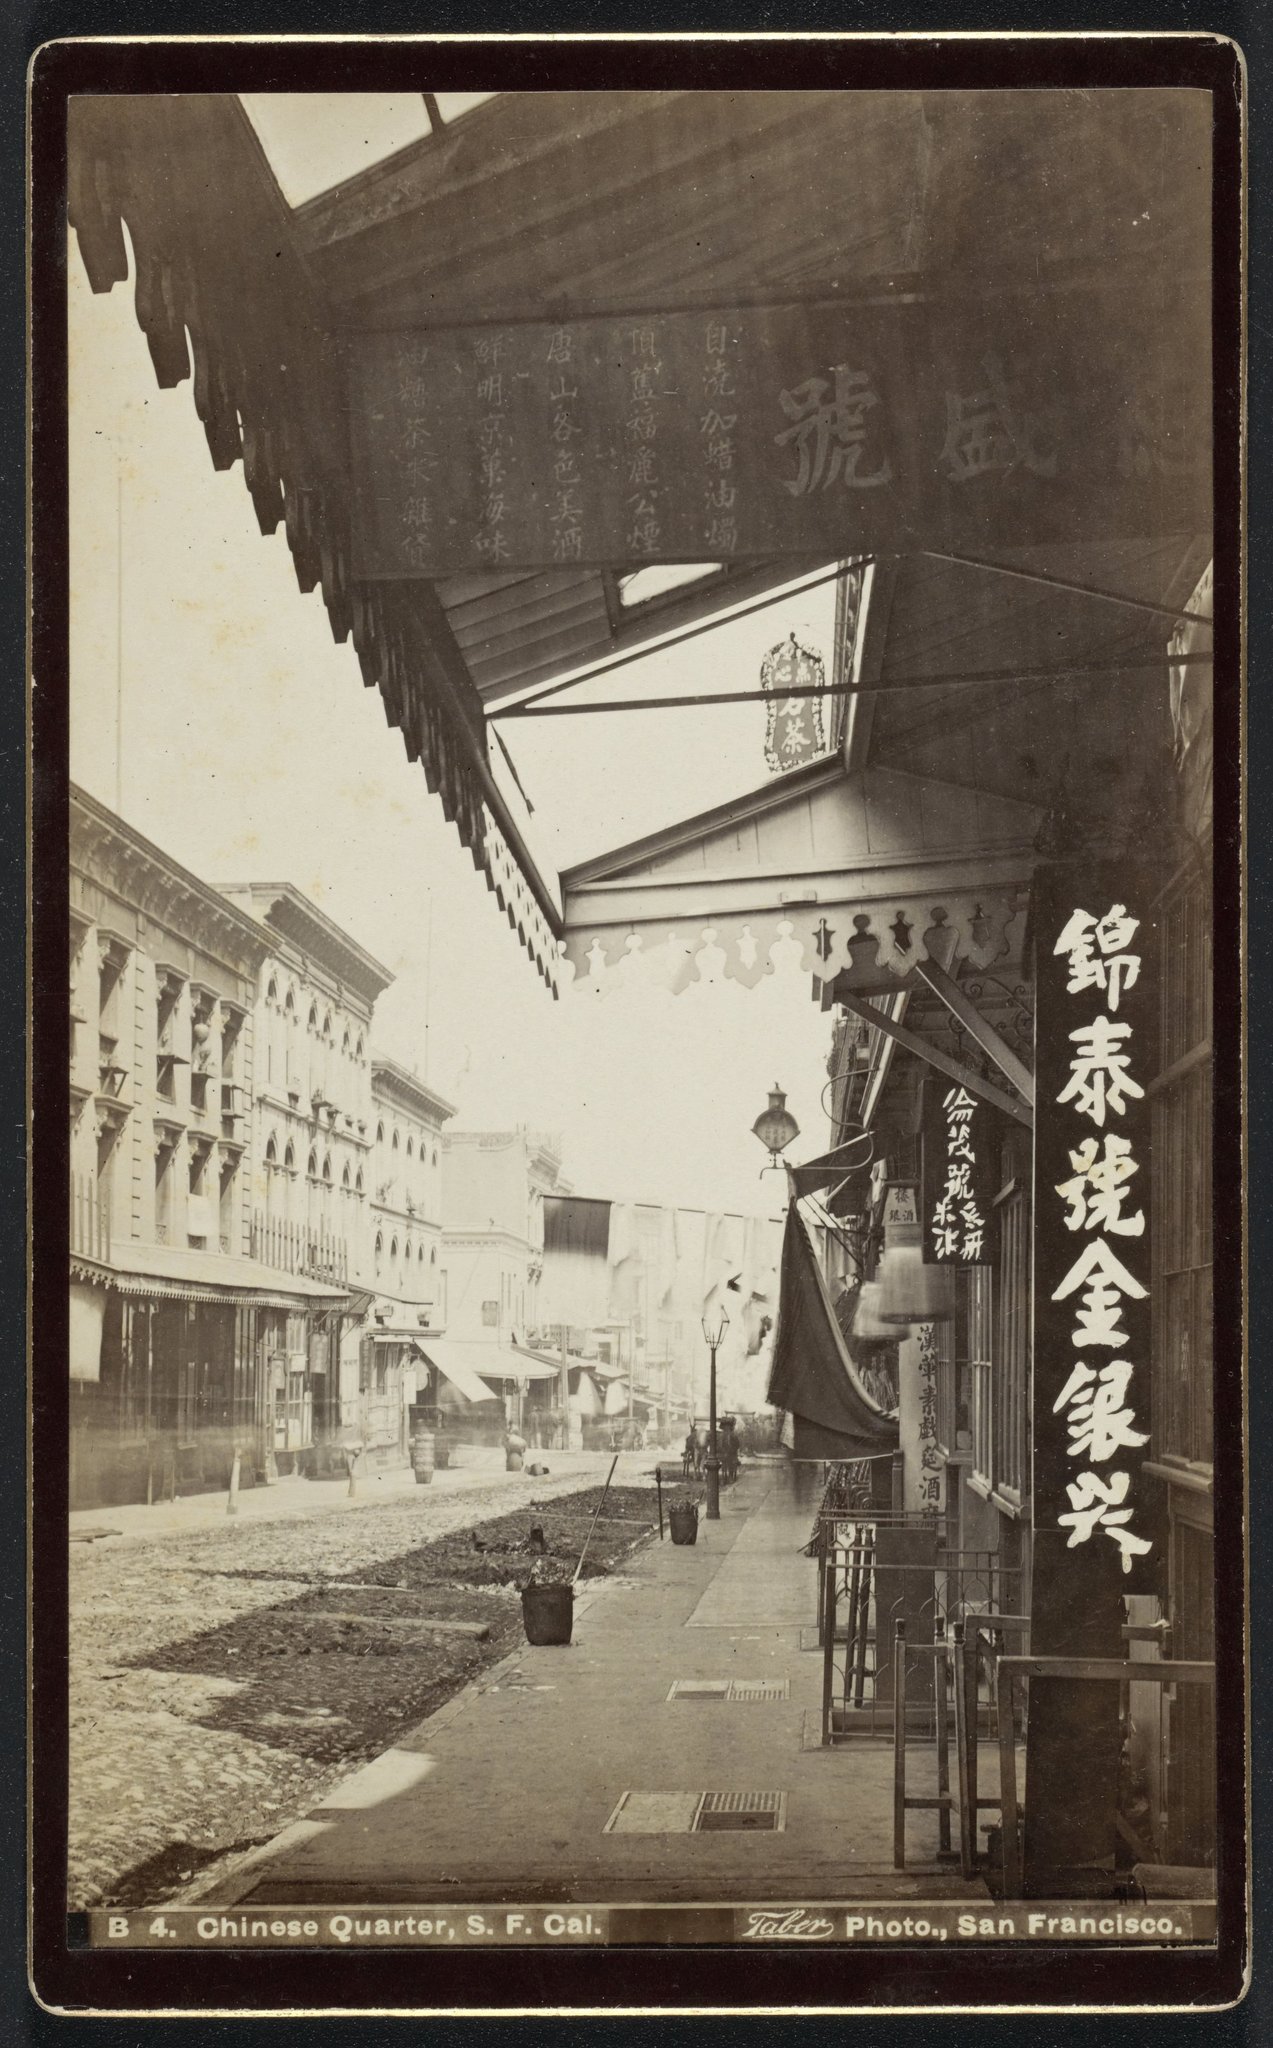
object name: photograph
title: Straat in Chinatown San Francisco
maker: isaiah west taber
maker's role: fotograaf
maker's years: 1830-1912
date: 1890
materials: cardboard, paper, photographic support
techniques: albumen print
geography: chinatown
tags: street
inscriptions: inscription: ‘China town in San Francisco. 1890’